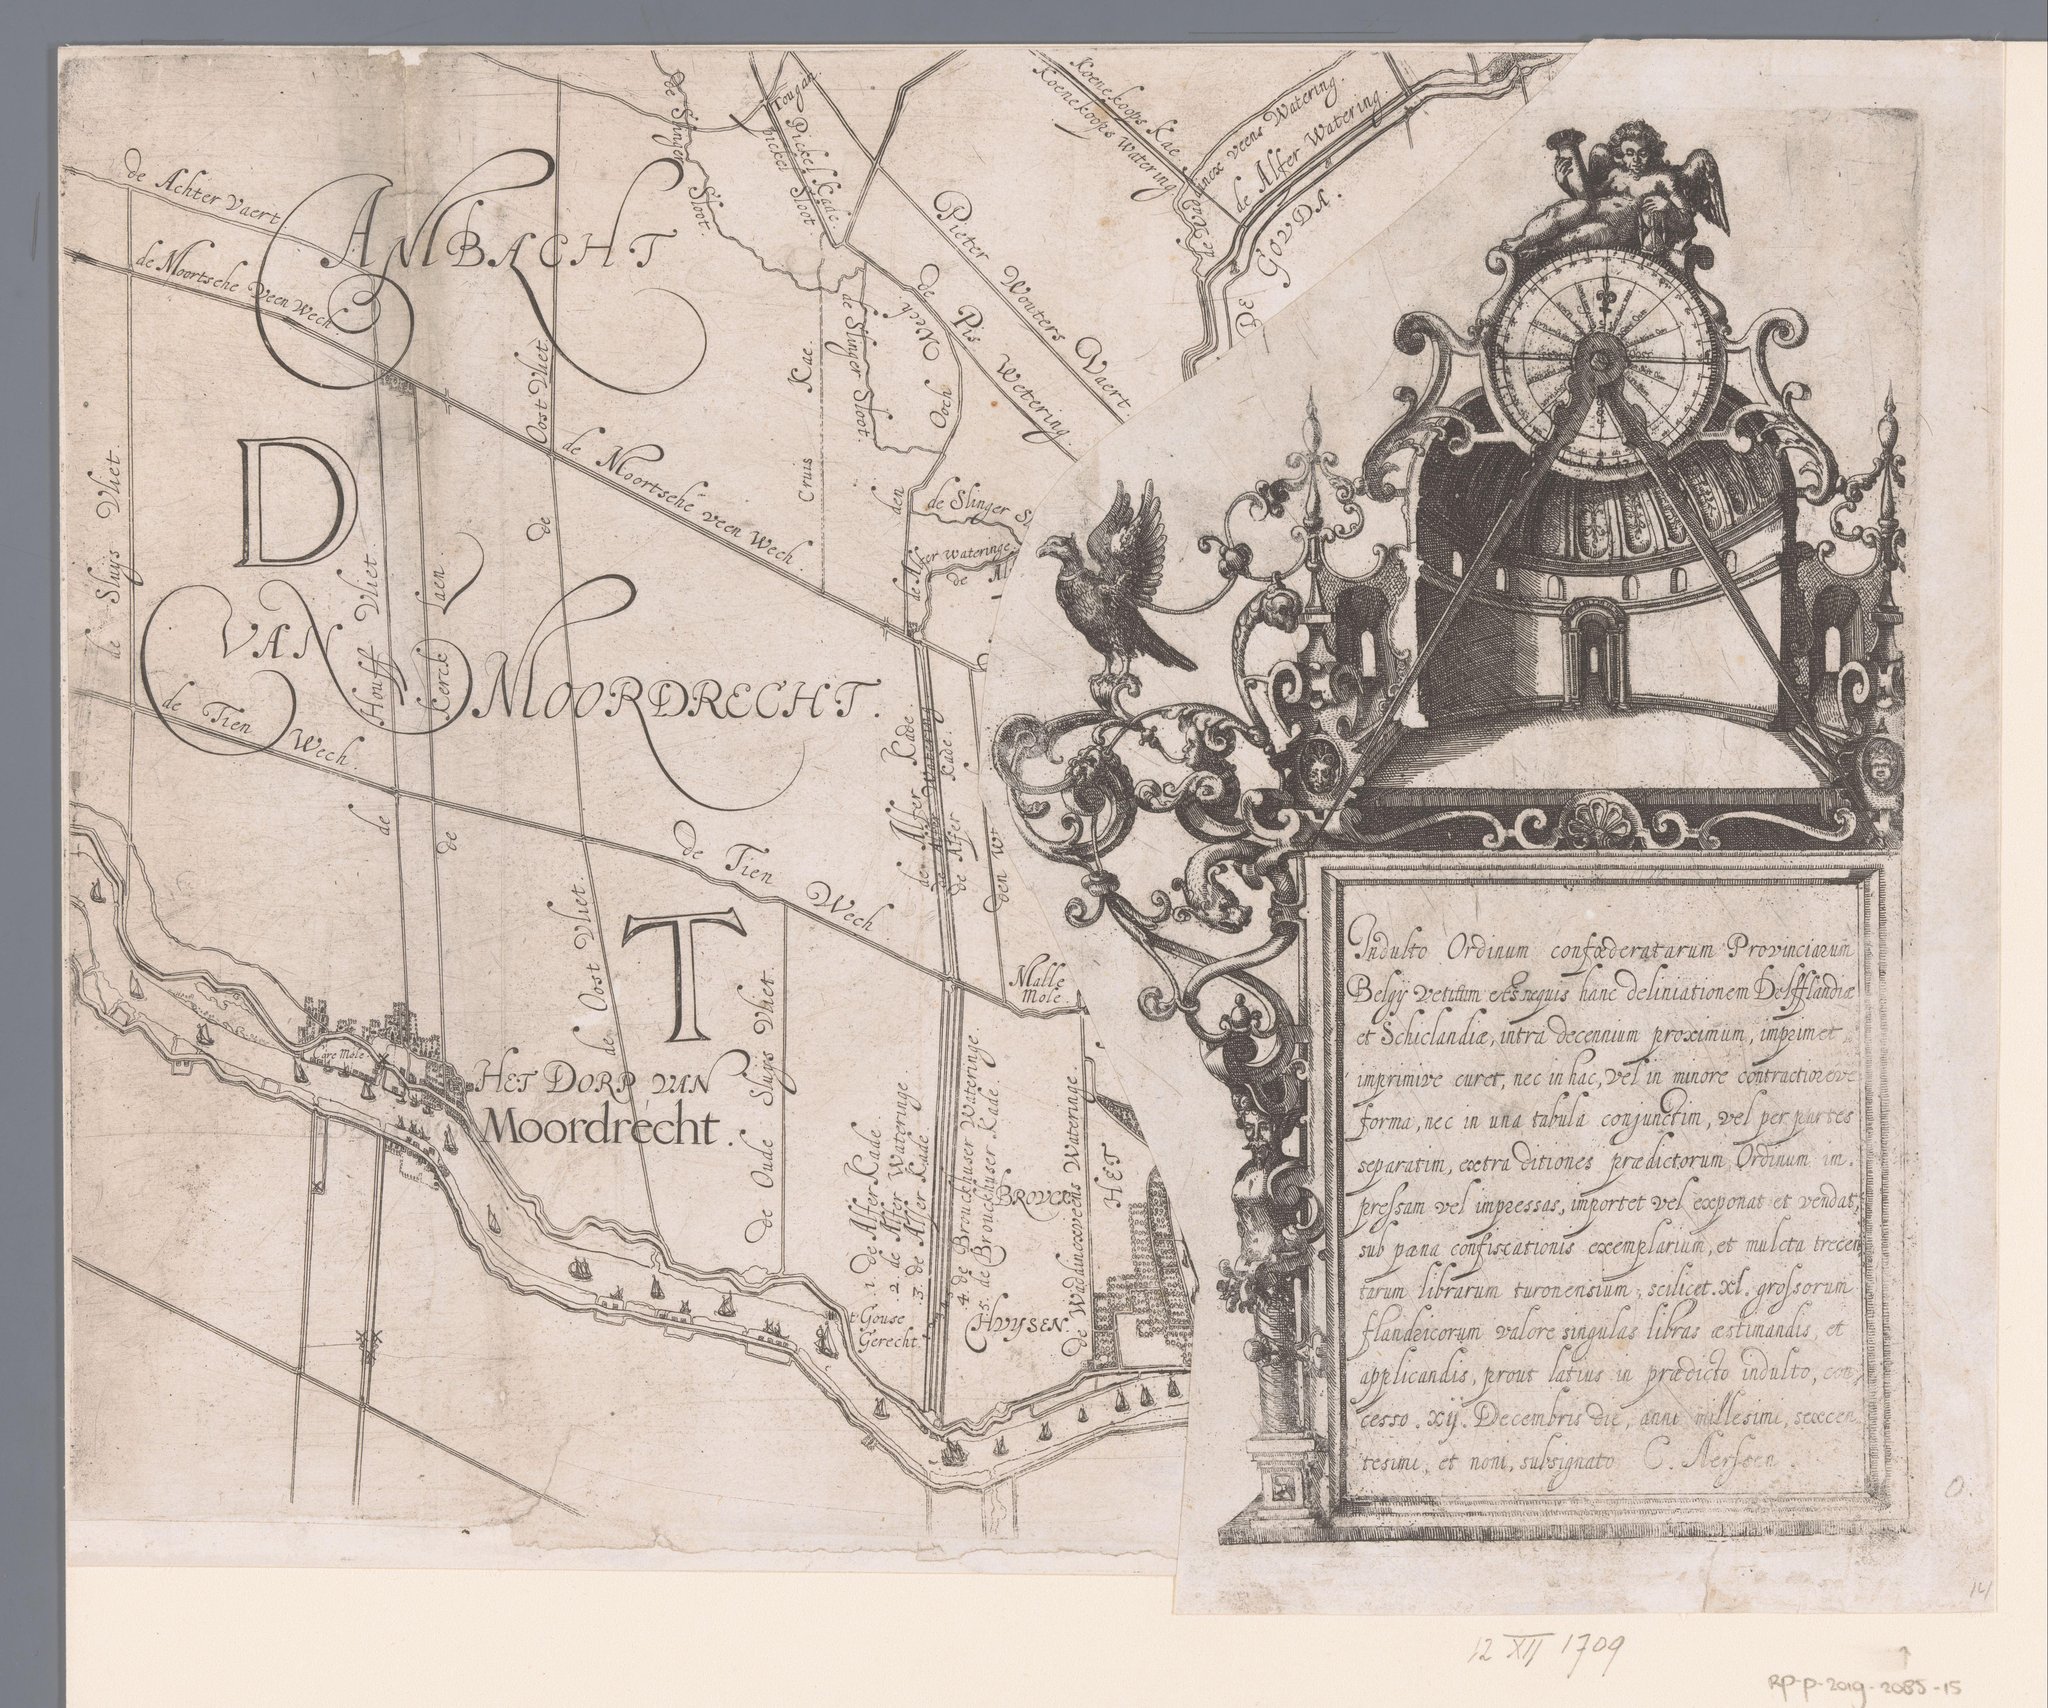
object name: map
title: Kaart van het Hoogheemraadschap van Schieland, decoratief cartouche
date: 1611-1635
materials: paper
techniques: engraving, etching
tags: maps of separate countries or regions, armorial bearing, heraldry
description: Cartouche geplakt over het blad met het kaartdeel met Gouda en Moordrecht (zelfde deel als RP-P-2019-2085-14). Op verso van het blad enkele proefdrukken van dit kaartdeel over elkaar heen gedrukt. Deze cartouche is dezelfde cartouche als die van Berckenrodes kaart van Delfland (zie RP-P-AO-11-5B). Onduidelijk of het ook bedoeld was om te gebruiken op de kaart van Schieland, in ieder geval alleen andere exemplaren van de kaart van Delfland met deze cartouche bekend. Deze kaart is tussen 1611 en 1635 vijf keer uitgegeven zonder dat de platen zijn bijgewerkt. Onduidelijk tot welke uitgave dit exemplaar behoort.